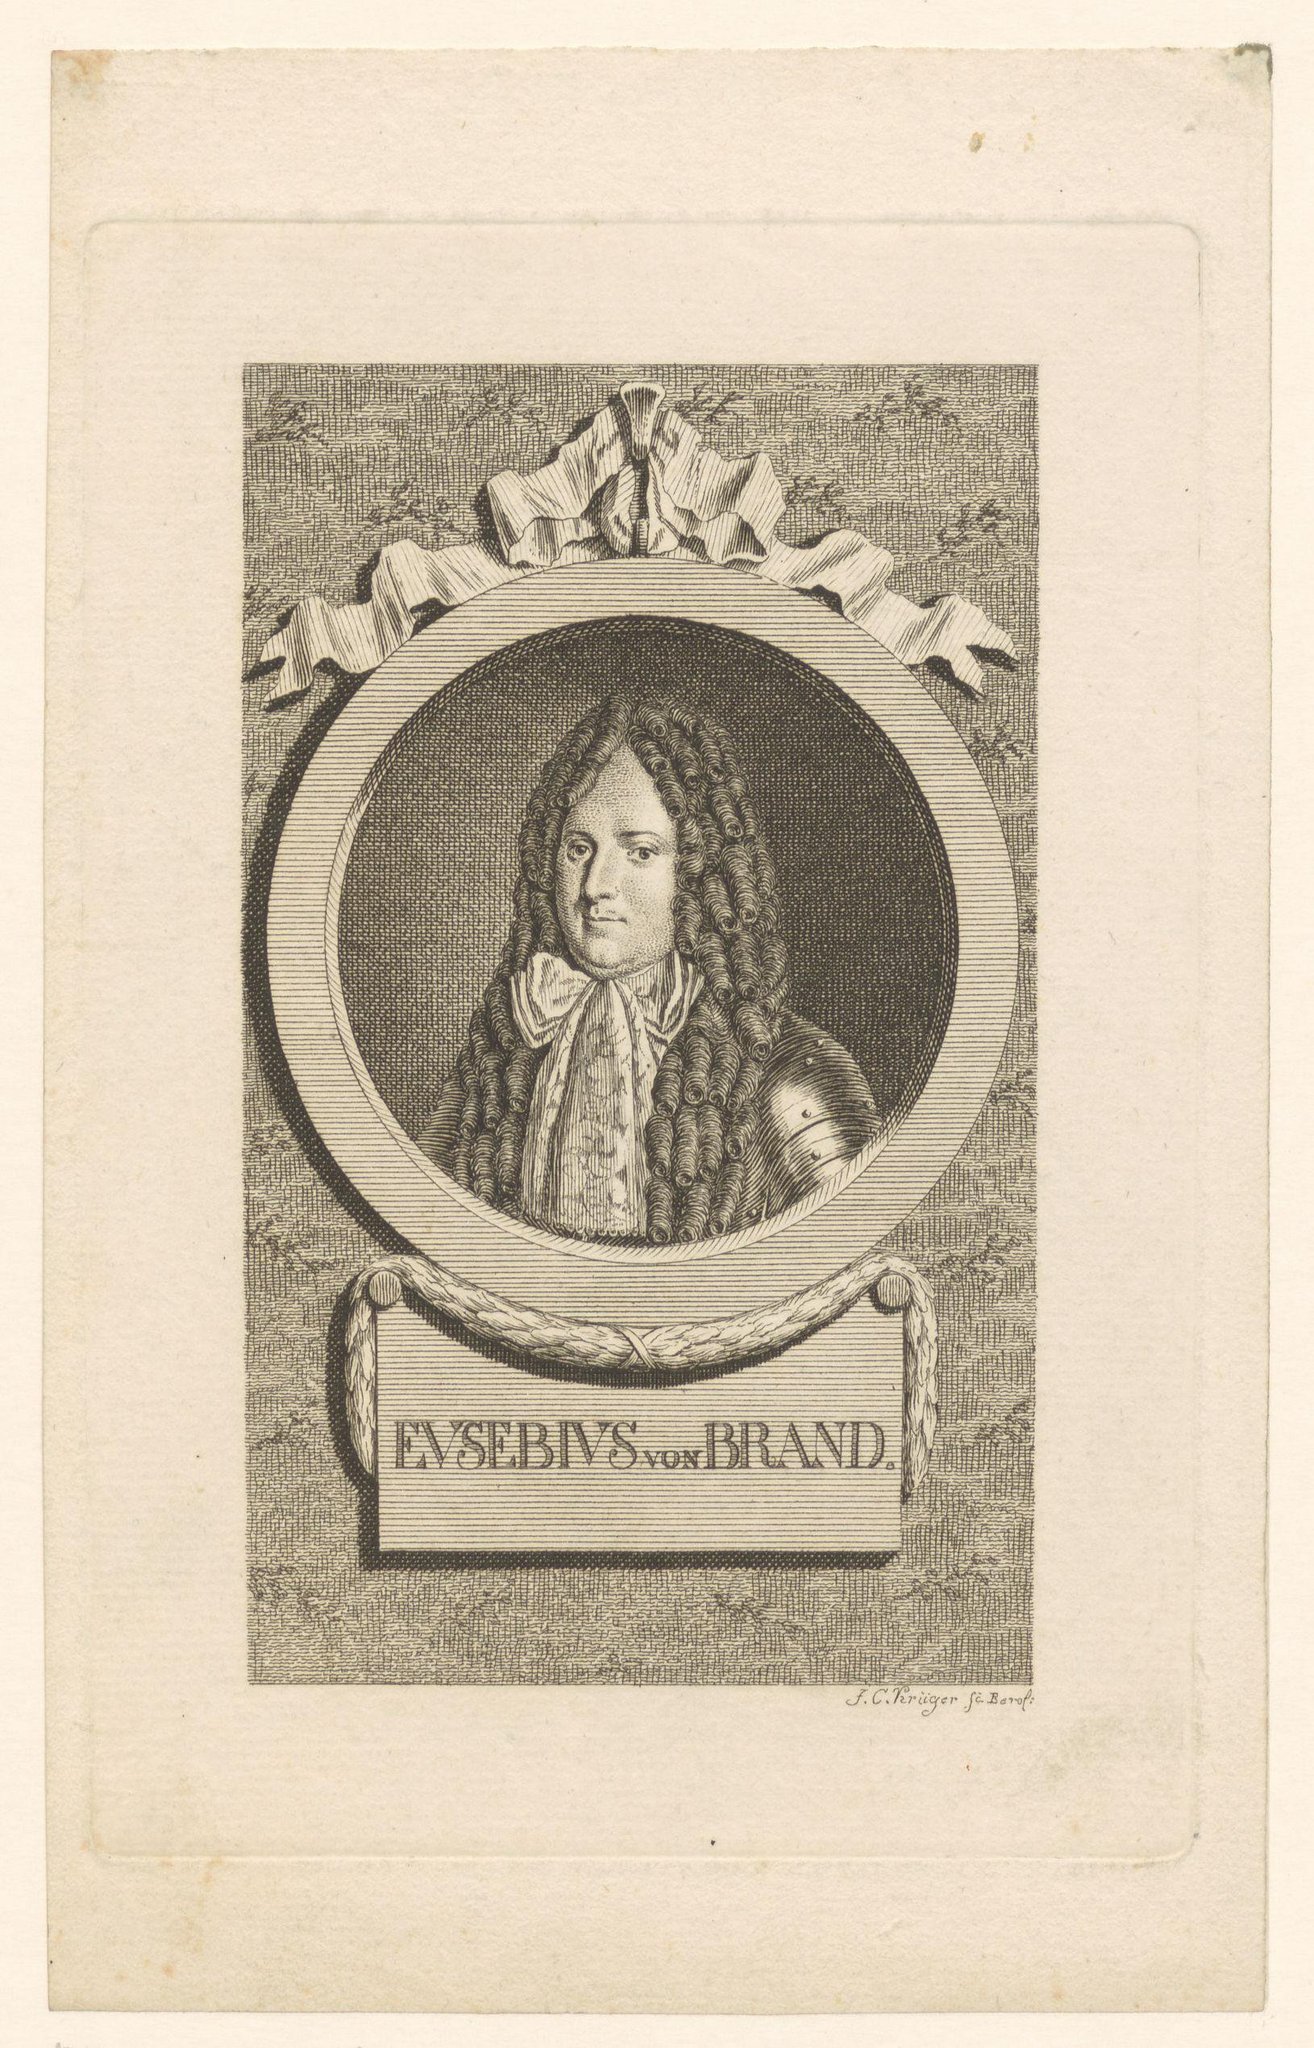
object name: print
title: Portret van Eusebius von Brandt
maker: johann conrad krüger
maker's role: artist, painter, print maker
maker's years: 1733-1791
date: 1743-1791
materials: paper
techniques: engraving, etching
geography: berlin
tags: berlin, historical persons, diplomacy, diplomat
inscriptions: collector's mark: Lugt 2228